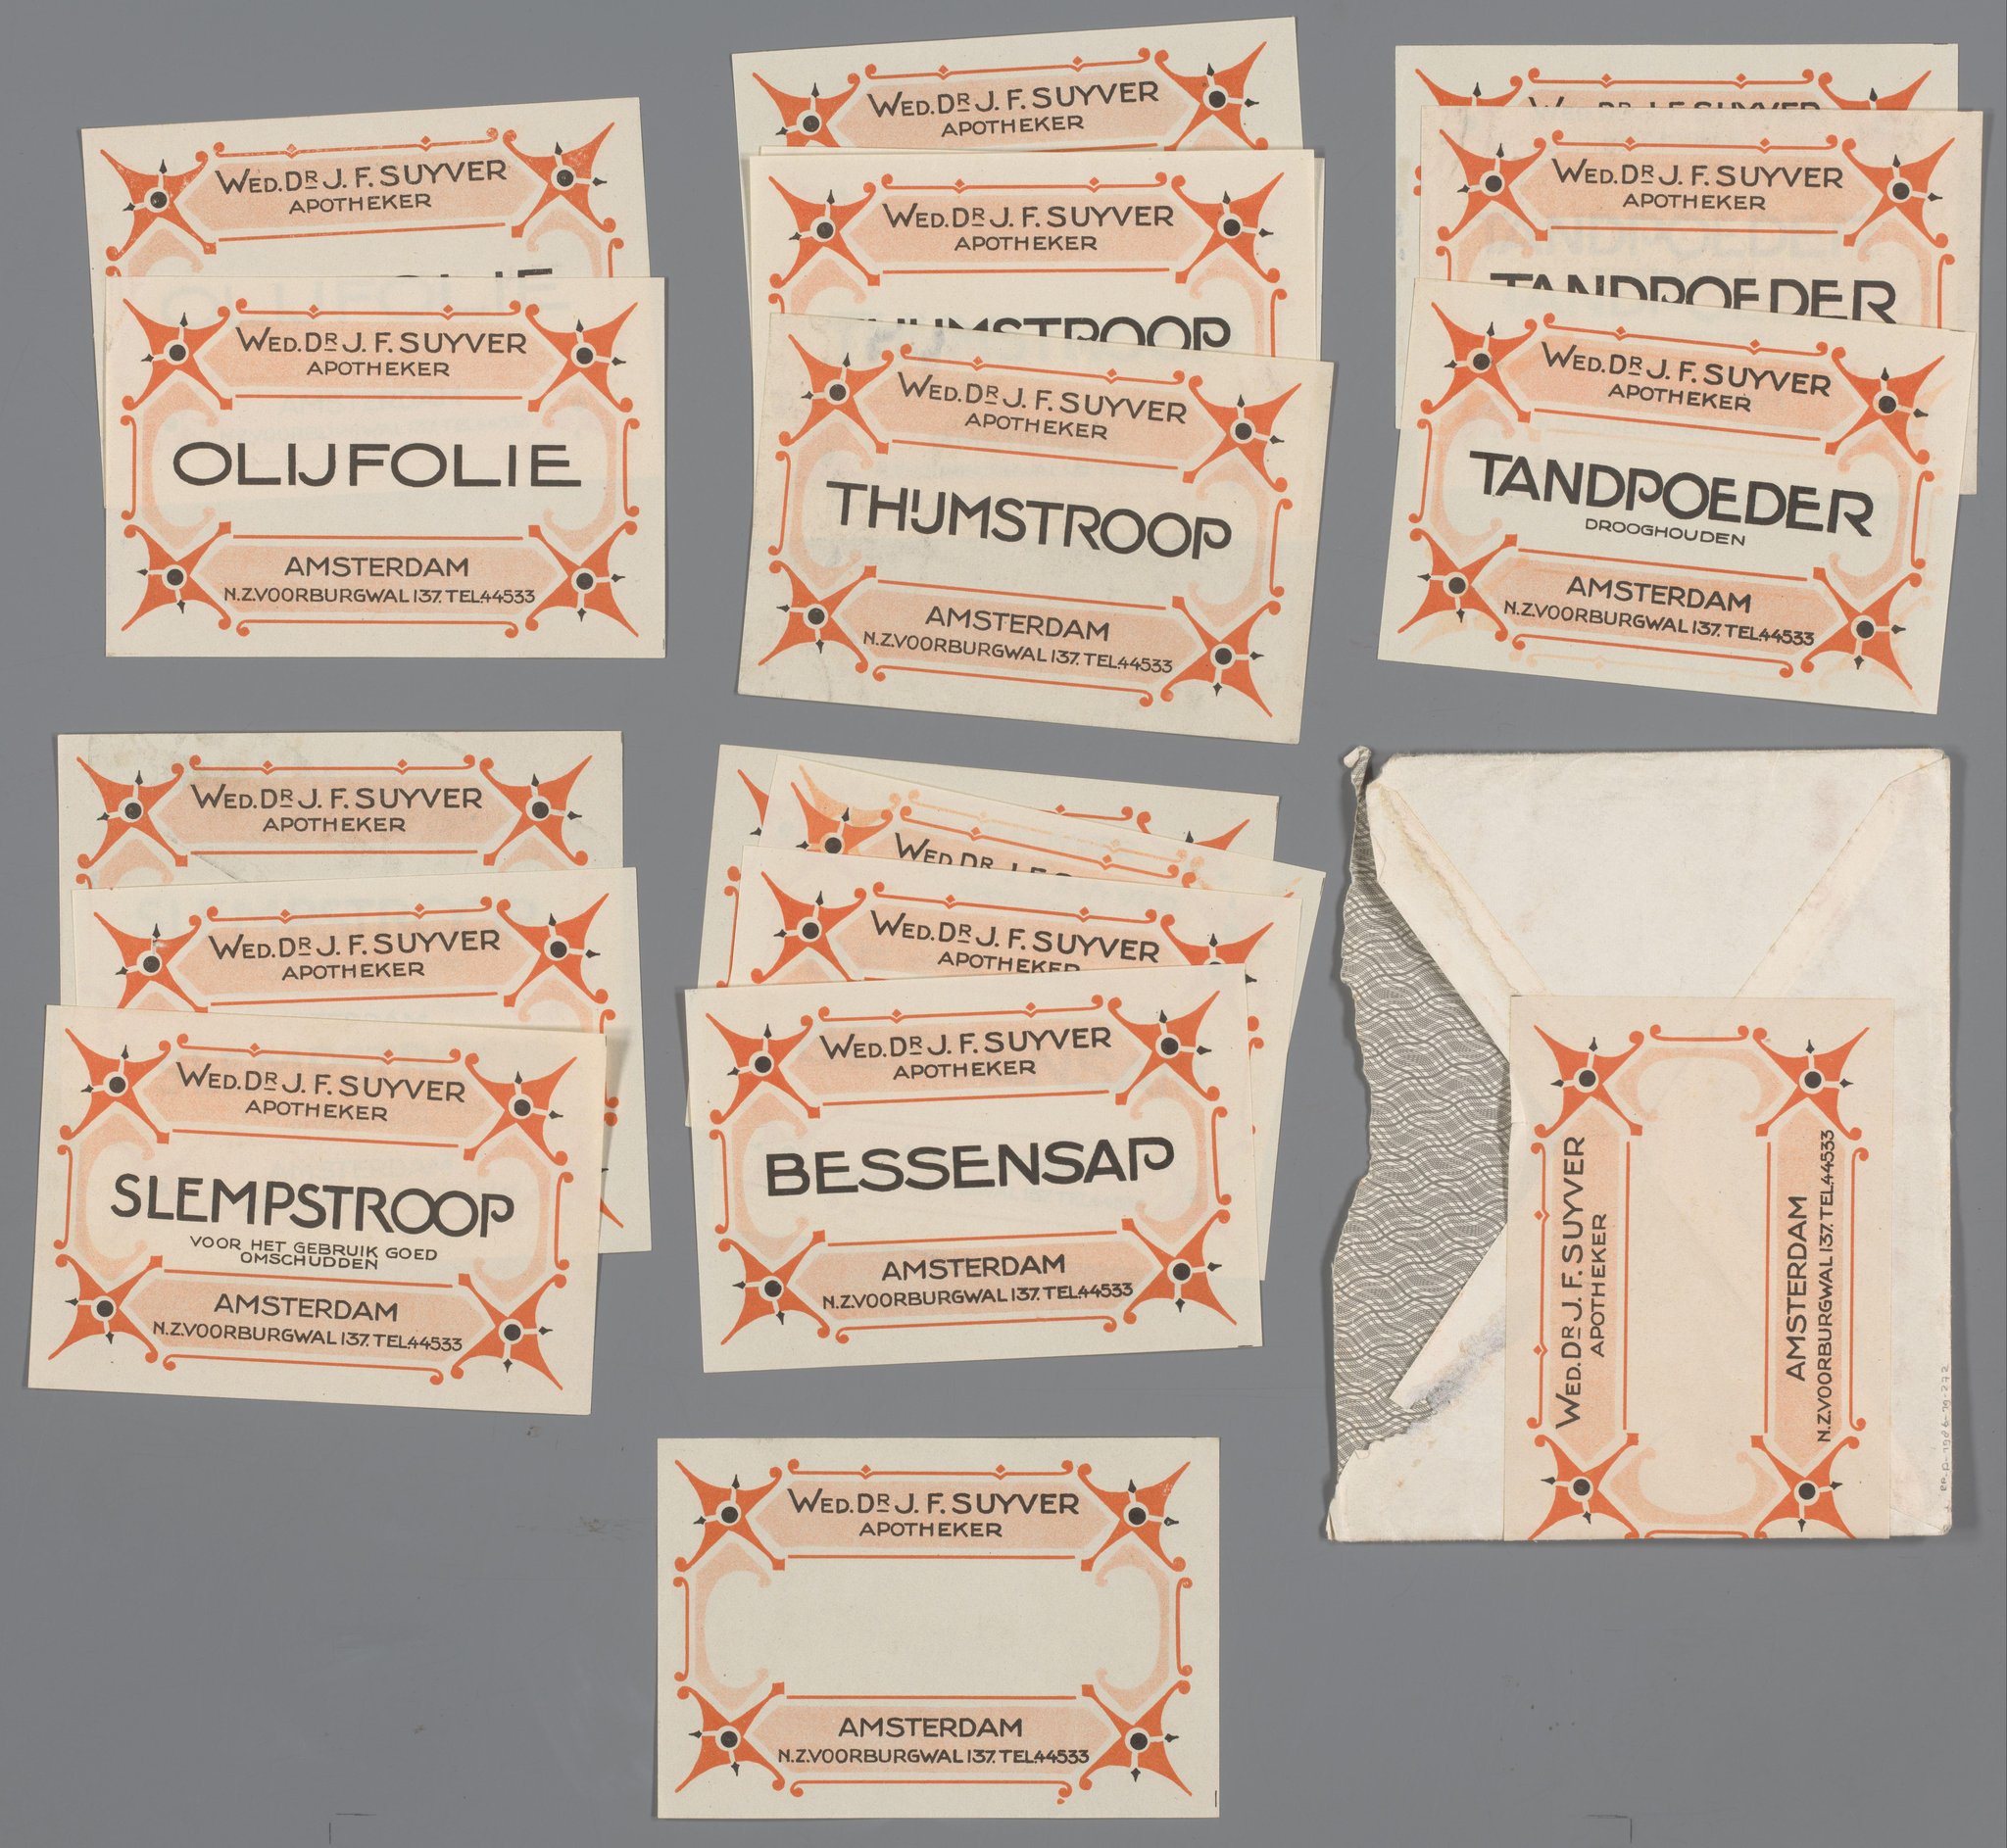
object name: print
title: Apothekersetiketten voor olijfolie, thijmstroop, tandpoeder, slempstroop en bessensap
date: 1931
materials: ink, paper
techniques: lithograph, pen, writing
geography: hilversum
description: Apothekersetiketten bewaard in een envelop van Steendrukkerij De Jong & Co te Hilversum geadresseerd aan R.W.P. de Vries Jr.